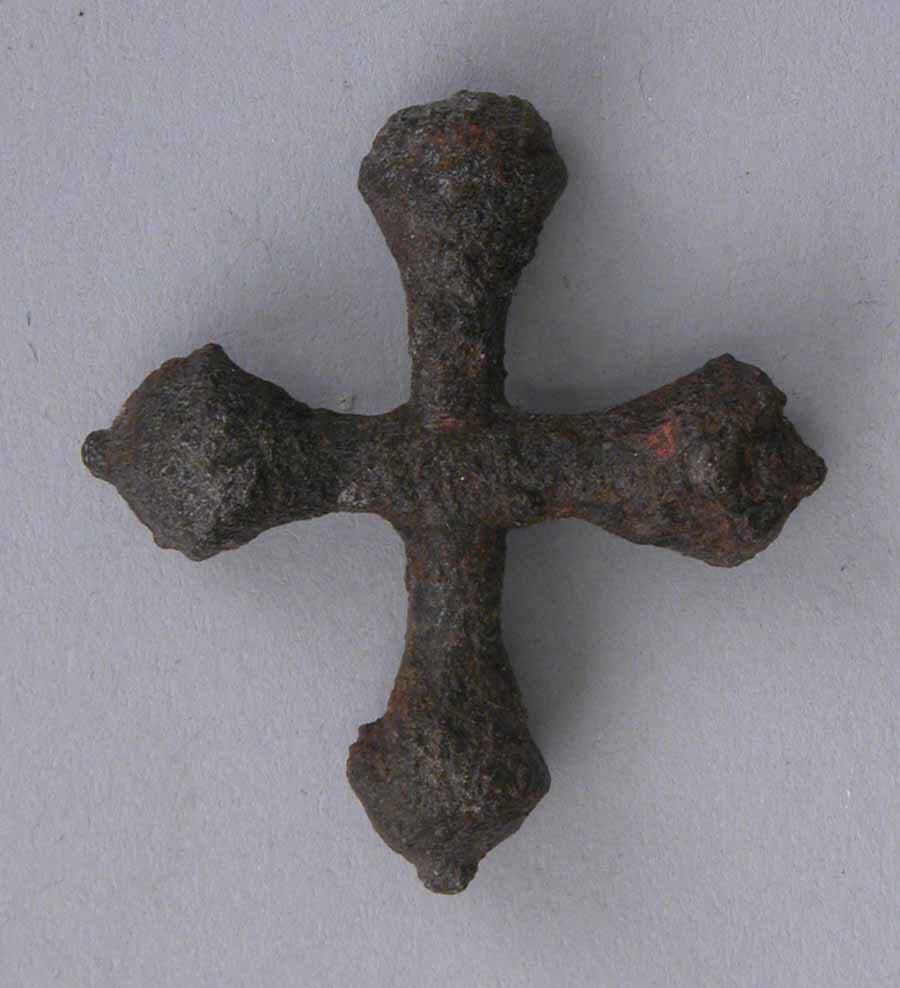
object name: cross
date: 201-1200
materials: iron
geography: egypt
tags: cross